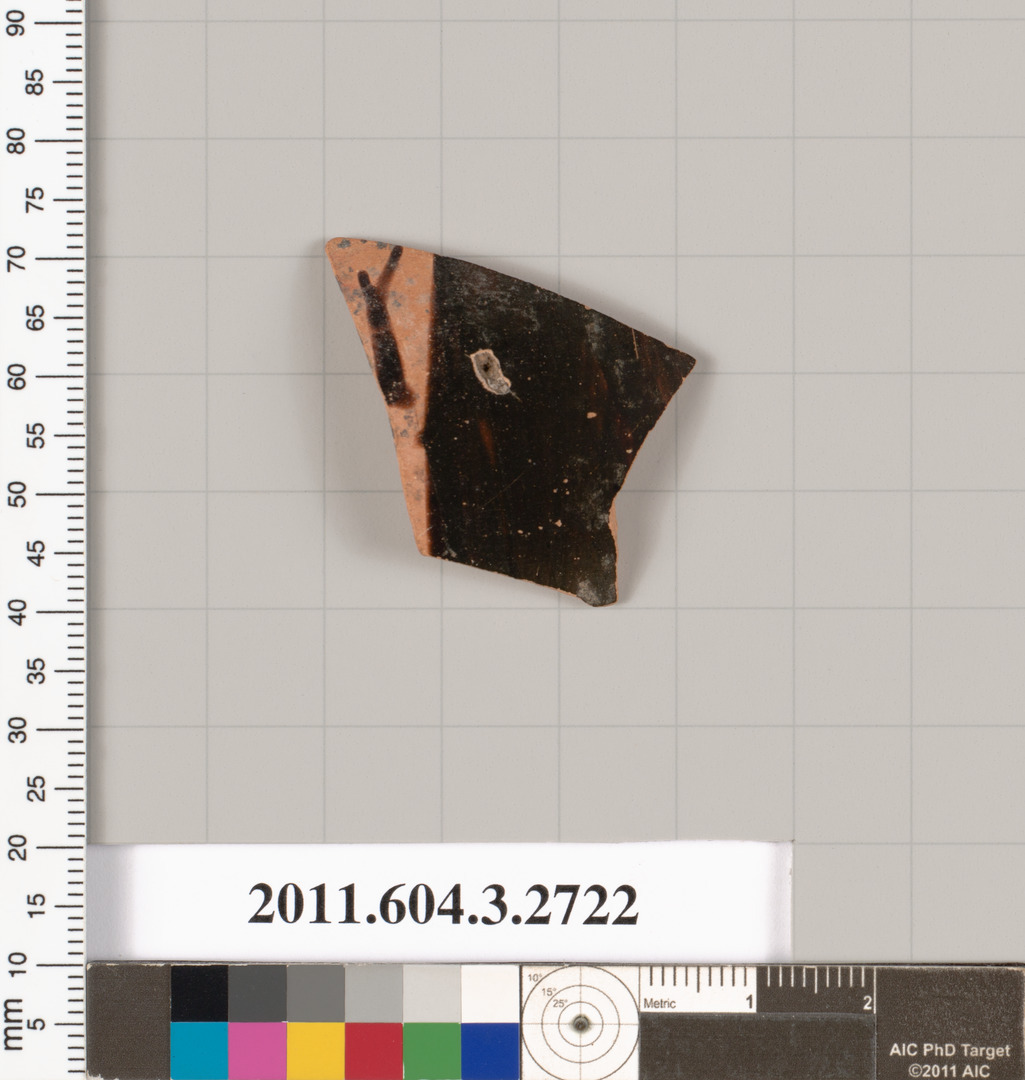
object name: oinochoe fragment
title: Terracotta fragment of an oinochoe (jug)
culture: greek, attic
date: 534-468 BCE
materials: terracotta